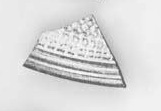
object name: shard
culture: korean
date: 1401-1500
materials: pottery